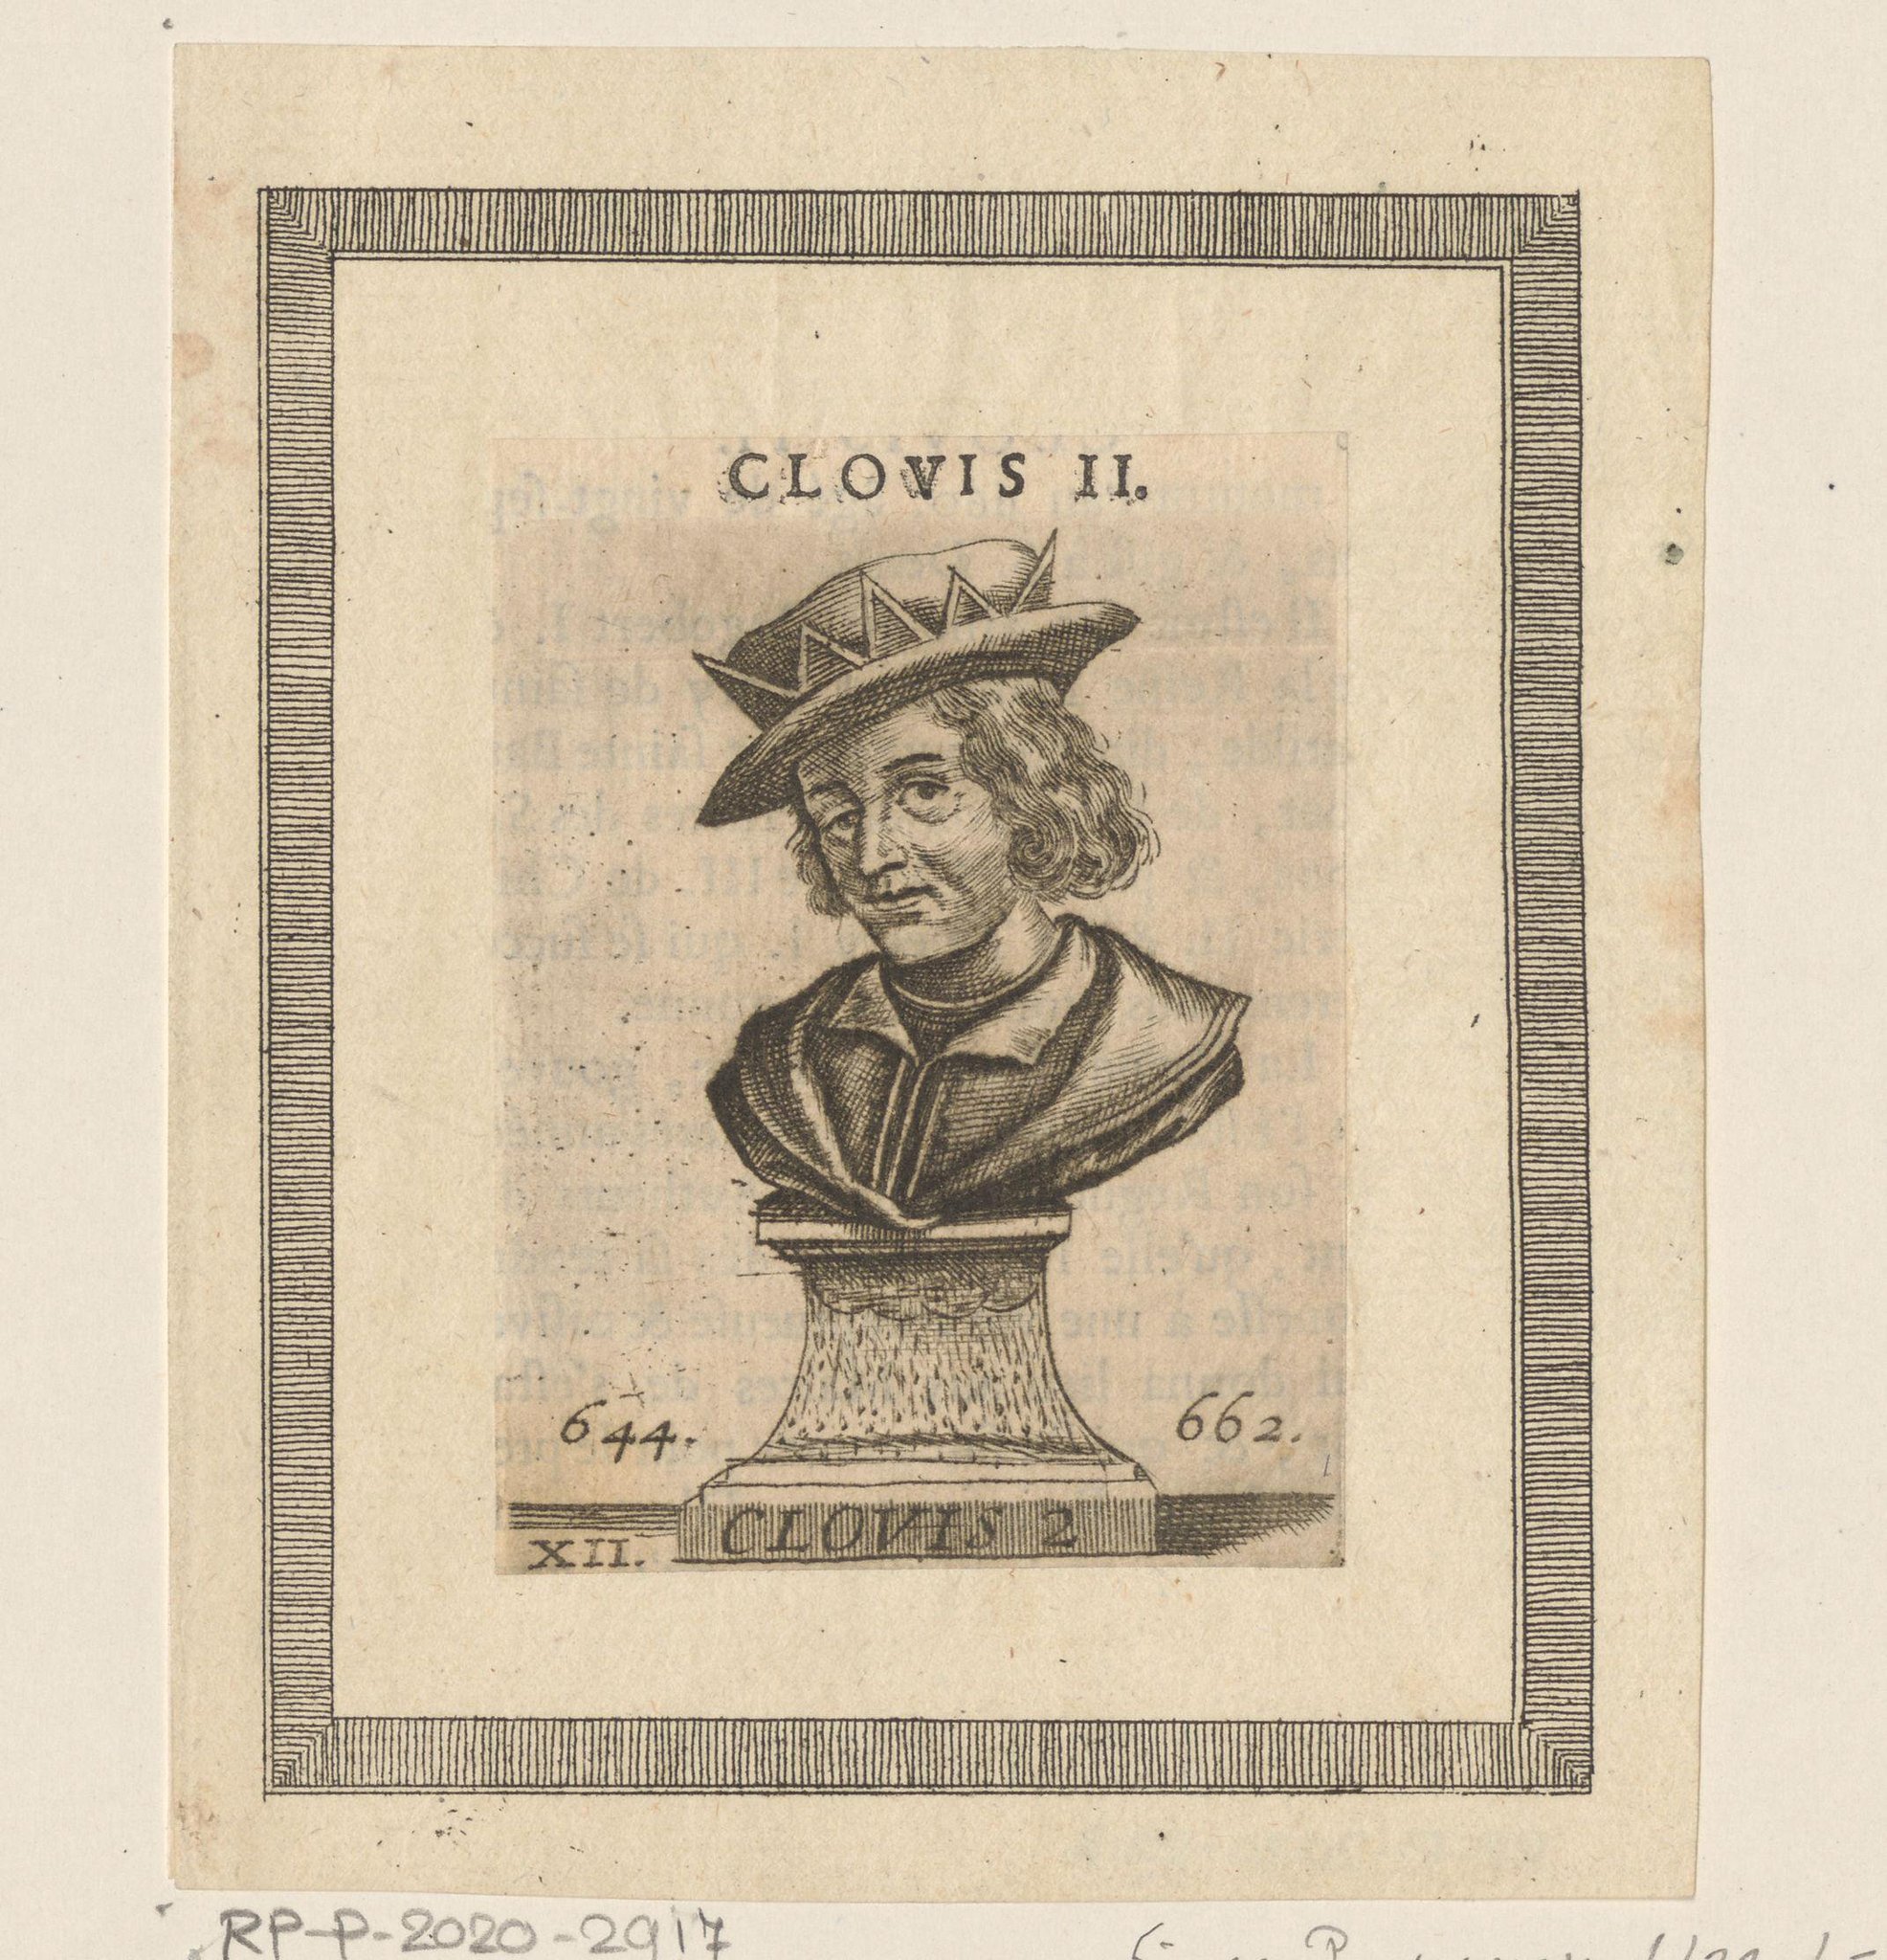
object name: print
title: Portret van Clovis II, koning van Neustrië en Bourgondië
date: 1667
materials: paper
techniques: engraving, etching, letterpress printing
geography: paris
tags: historical persons, king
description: Prent uit: Brianville, Claude Oronce Finé de. Abregé methodique de l'histoire de France: par la chronologie, la genealogie (...). Parijs: Charles de Sercy, 1667, p. 39. Prent gebruikt in eerdere (1664) en latere (1726) publicaties.